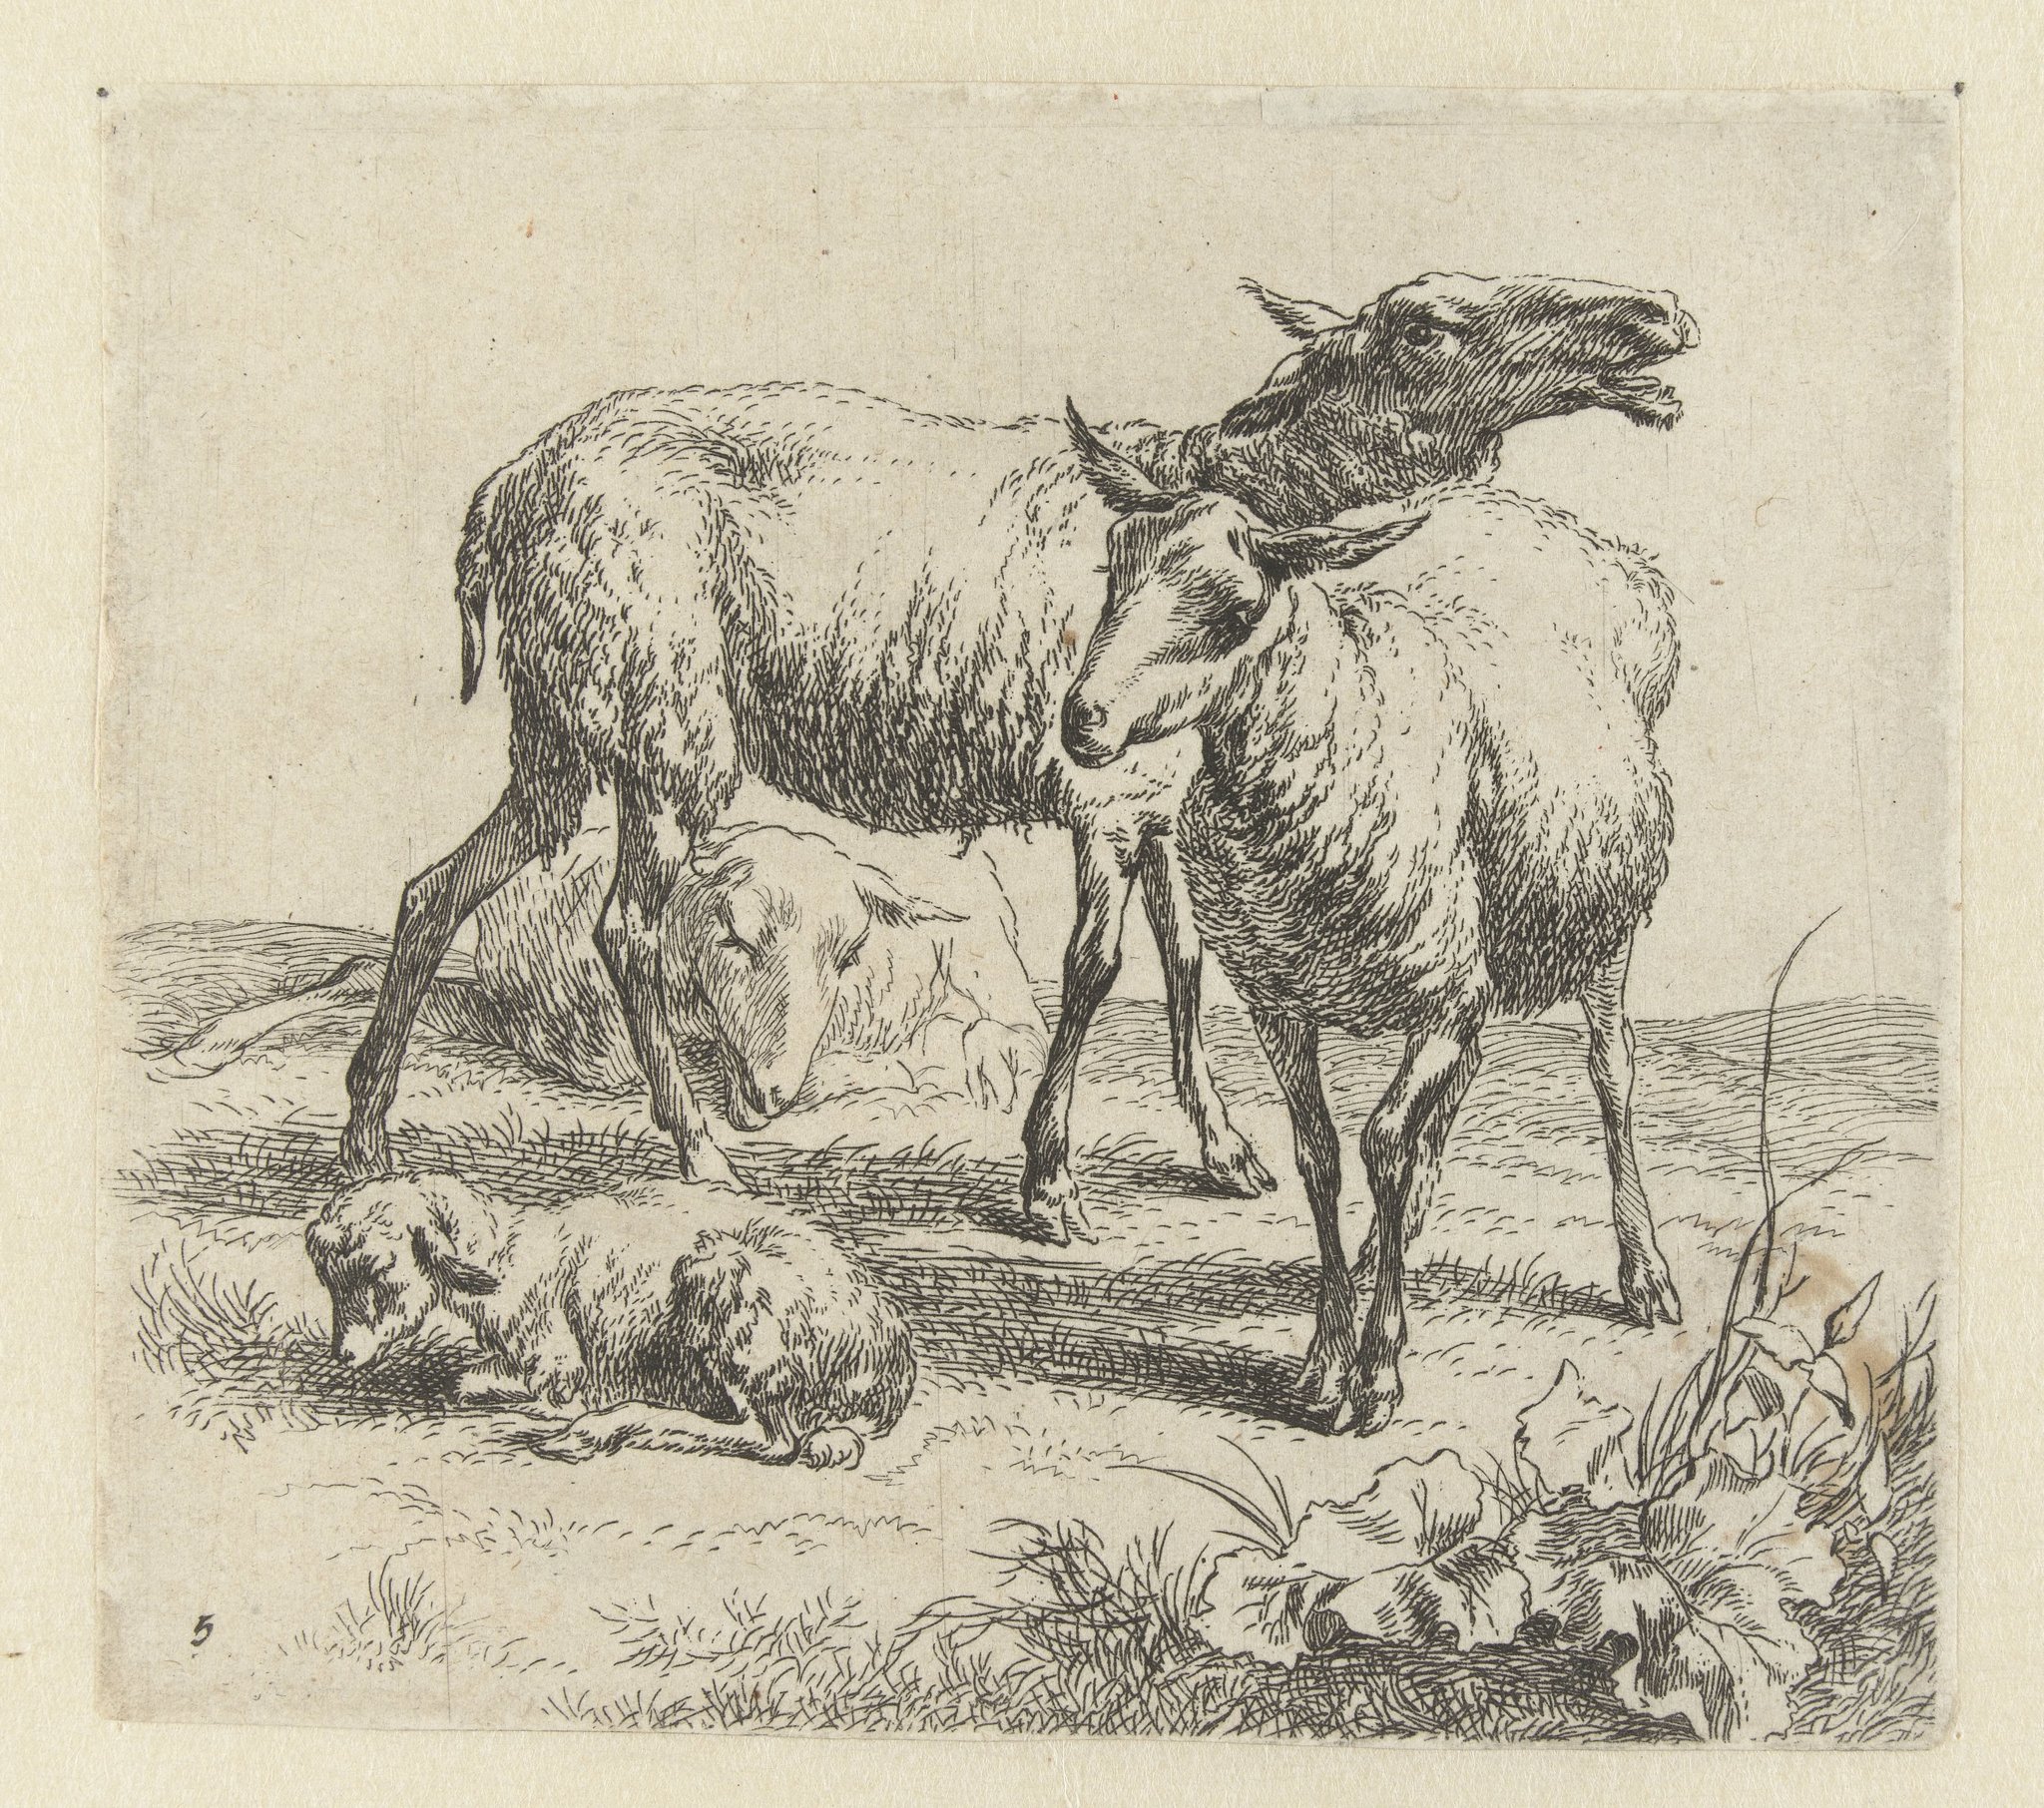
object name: print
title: Schapen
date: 1646-1652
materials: paper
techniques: etching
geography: netherlands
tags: sheep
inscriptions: collector's mark: Lugt 240